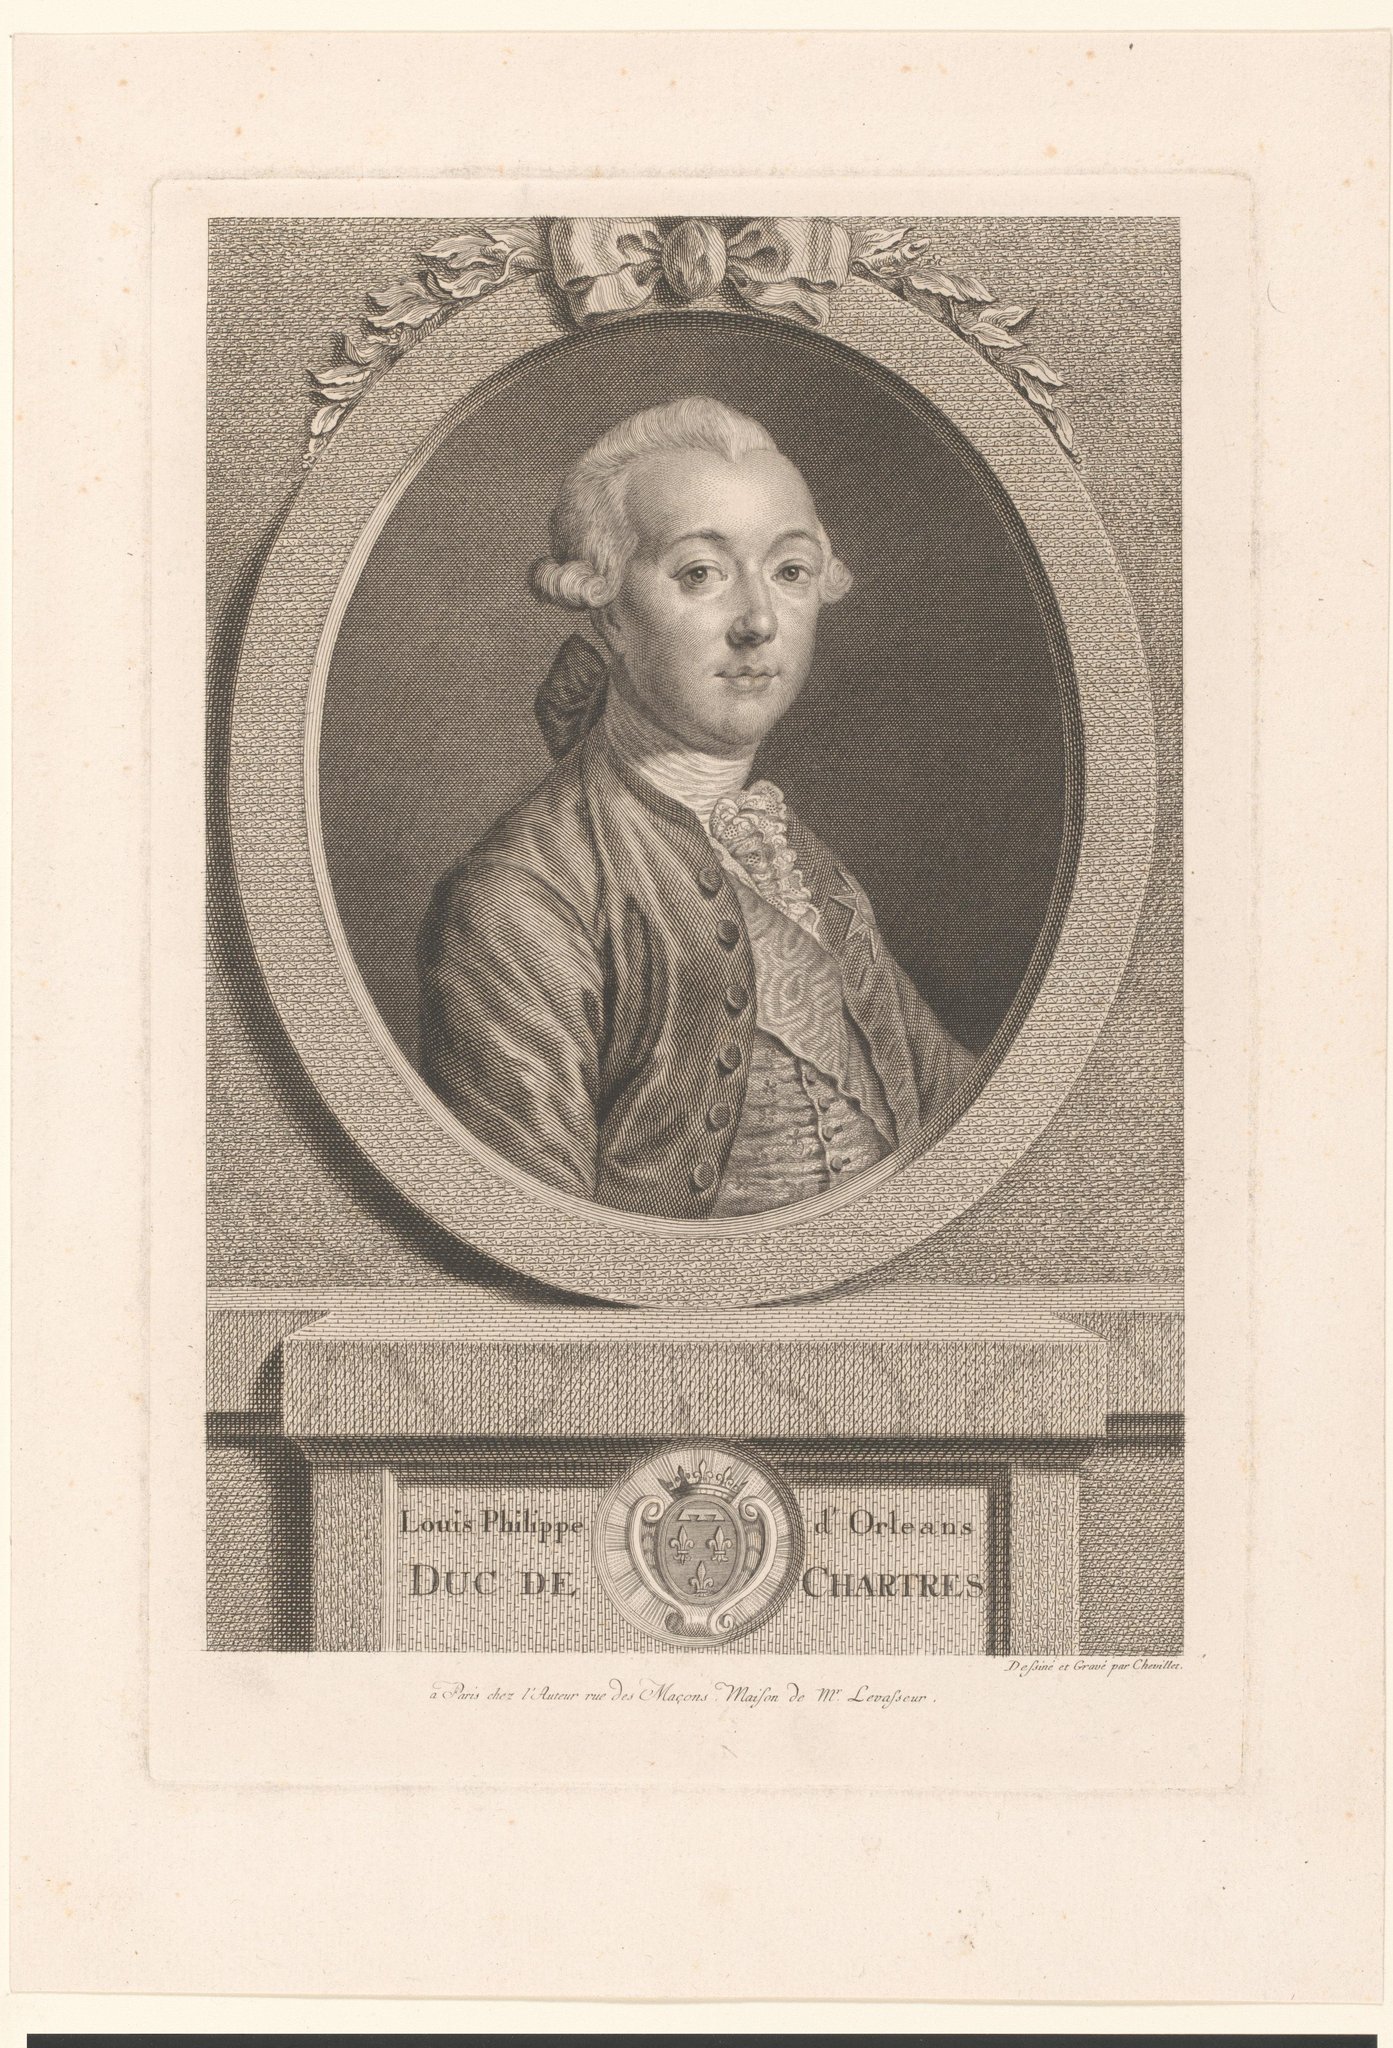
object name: print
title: Louis Philippe d'Orleans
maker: justus chevillet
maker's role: draughtsman, print maker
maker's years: 1729-1802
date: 1767-1802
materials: paper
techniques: engraving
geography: paris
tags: paris, lodewijk filips ii (hertog van orléans), ornament ~ medallion, historical persons, armorial bearing, heraldry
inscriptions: collector's mark: Lugt 2228